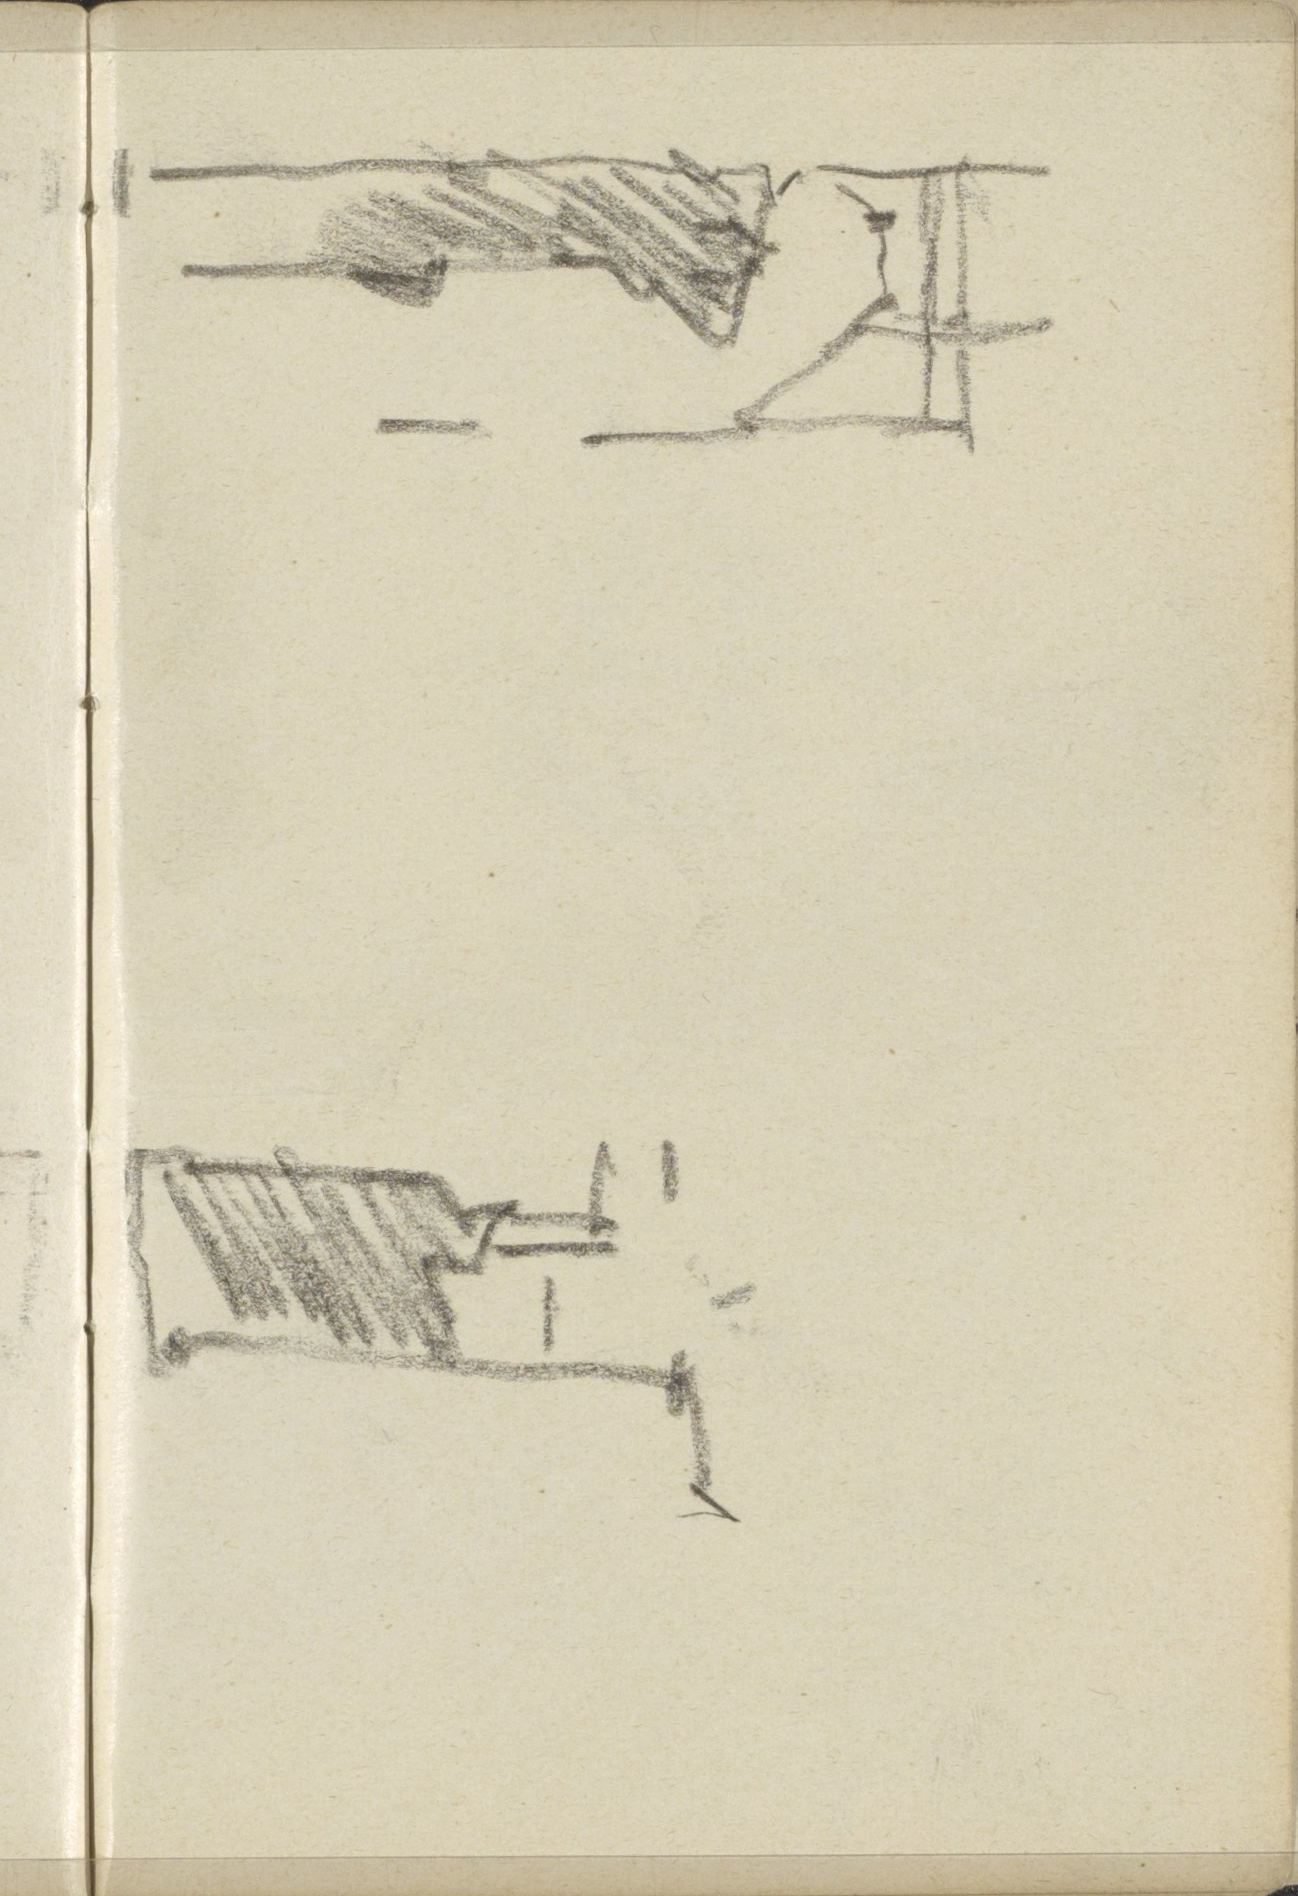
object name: sketchbook leaf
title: Gevelstudies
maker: george hendrik breitner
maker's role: draughtsman, painter, print maker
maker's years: 1857-1923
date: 1910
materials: chalk, paper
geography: amsterdam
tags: architecture, façade (of house or building), civic architecture; edifices; dwellings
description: Pagina 66 uit een schetsboek met 45 bladen.